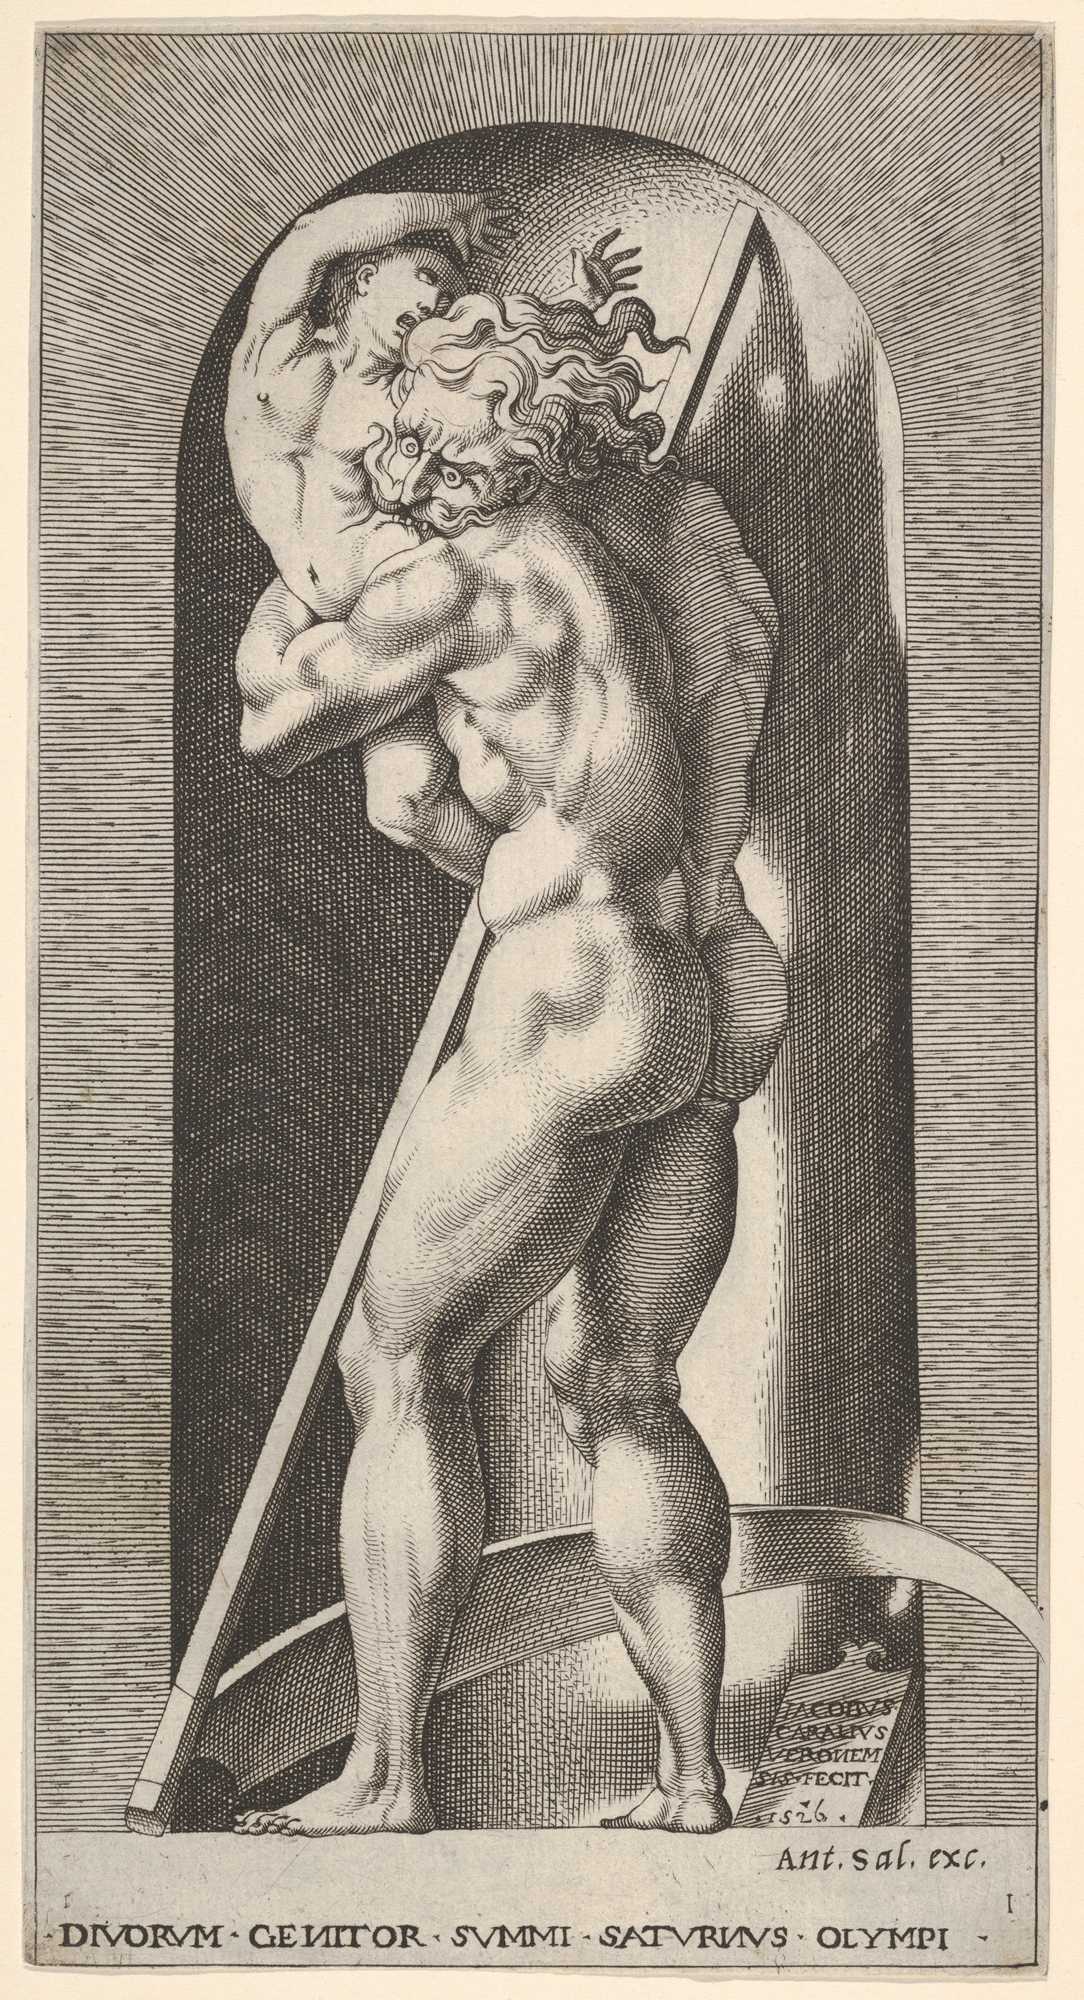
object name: print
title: Plate 1: Saturn in a niche devouring his son, standing before a scythe, from "Mythological Gods and Goddesses"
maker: giovanni jacopo caraglio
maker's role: artist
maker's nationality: italian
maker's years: 1500-1565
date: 1526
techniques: engraving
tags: saturn